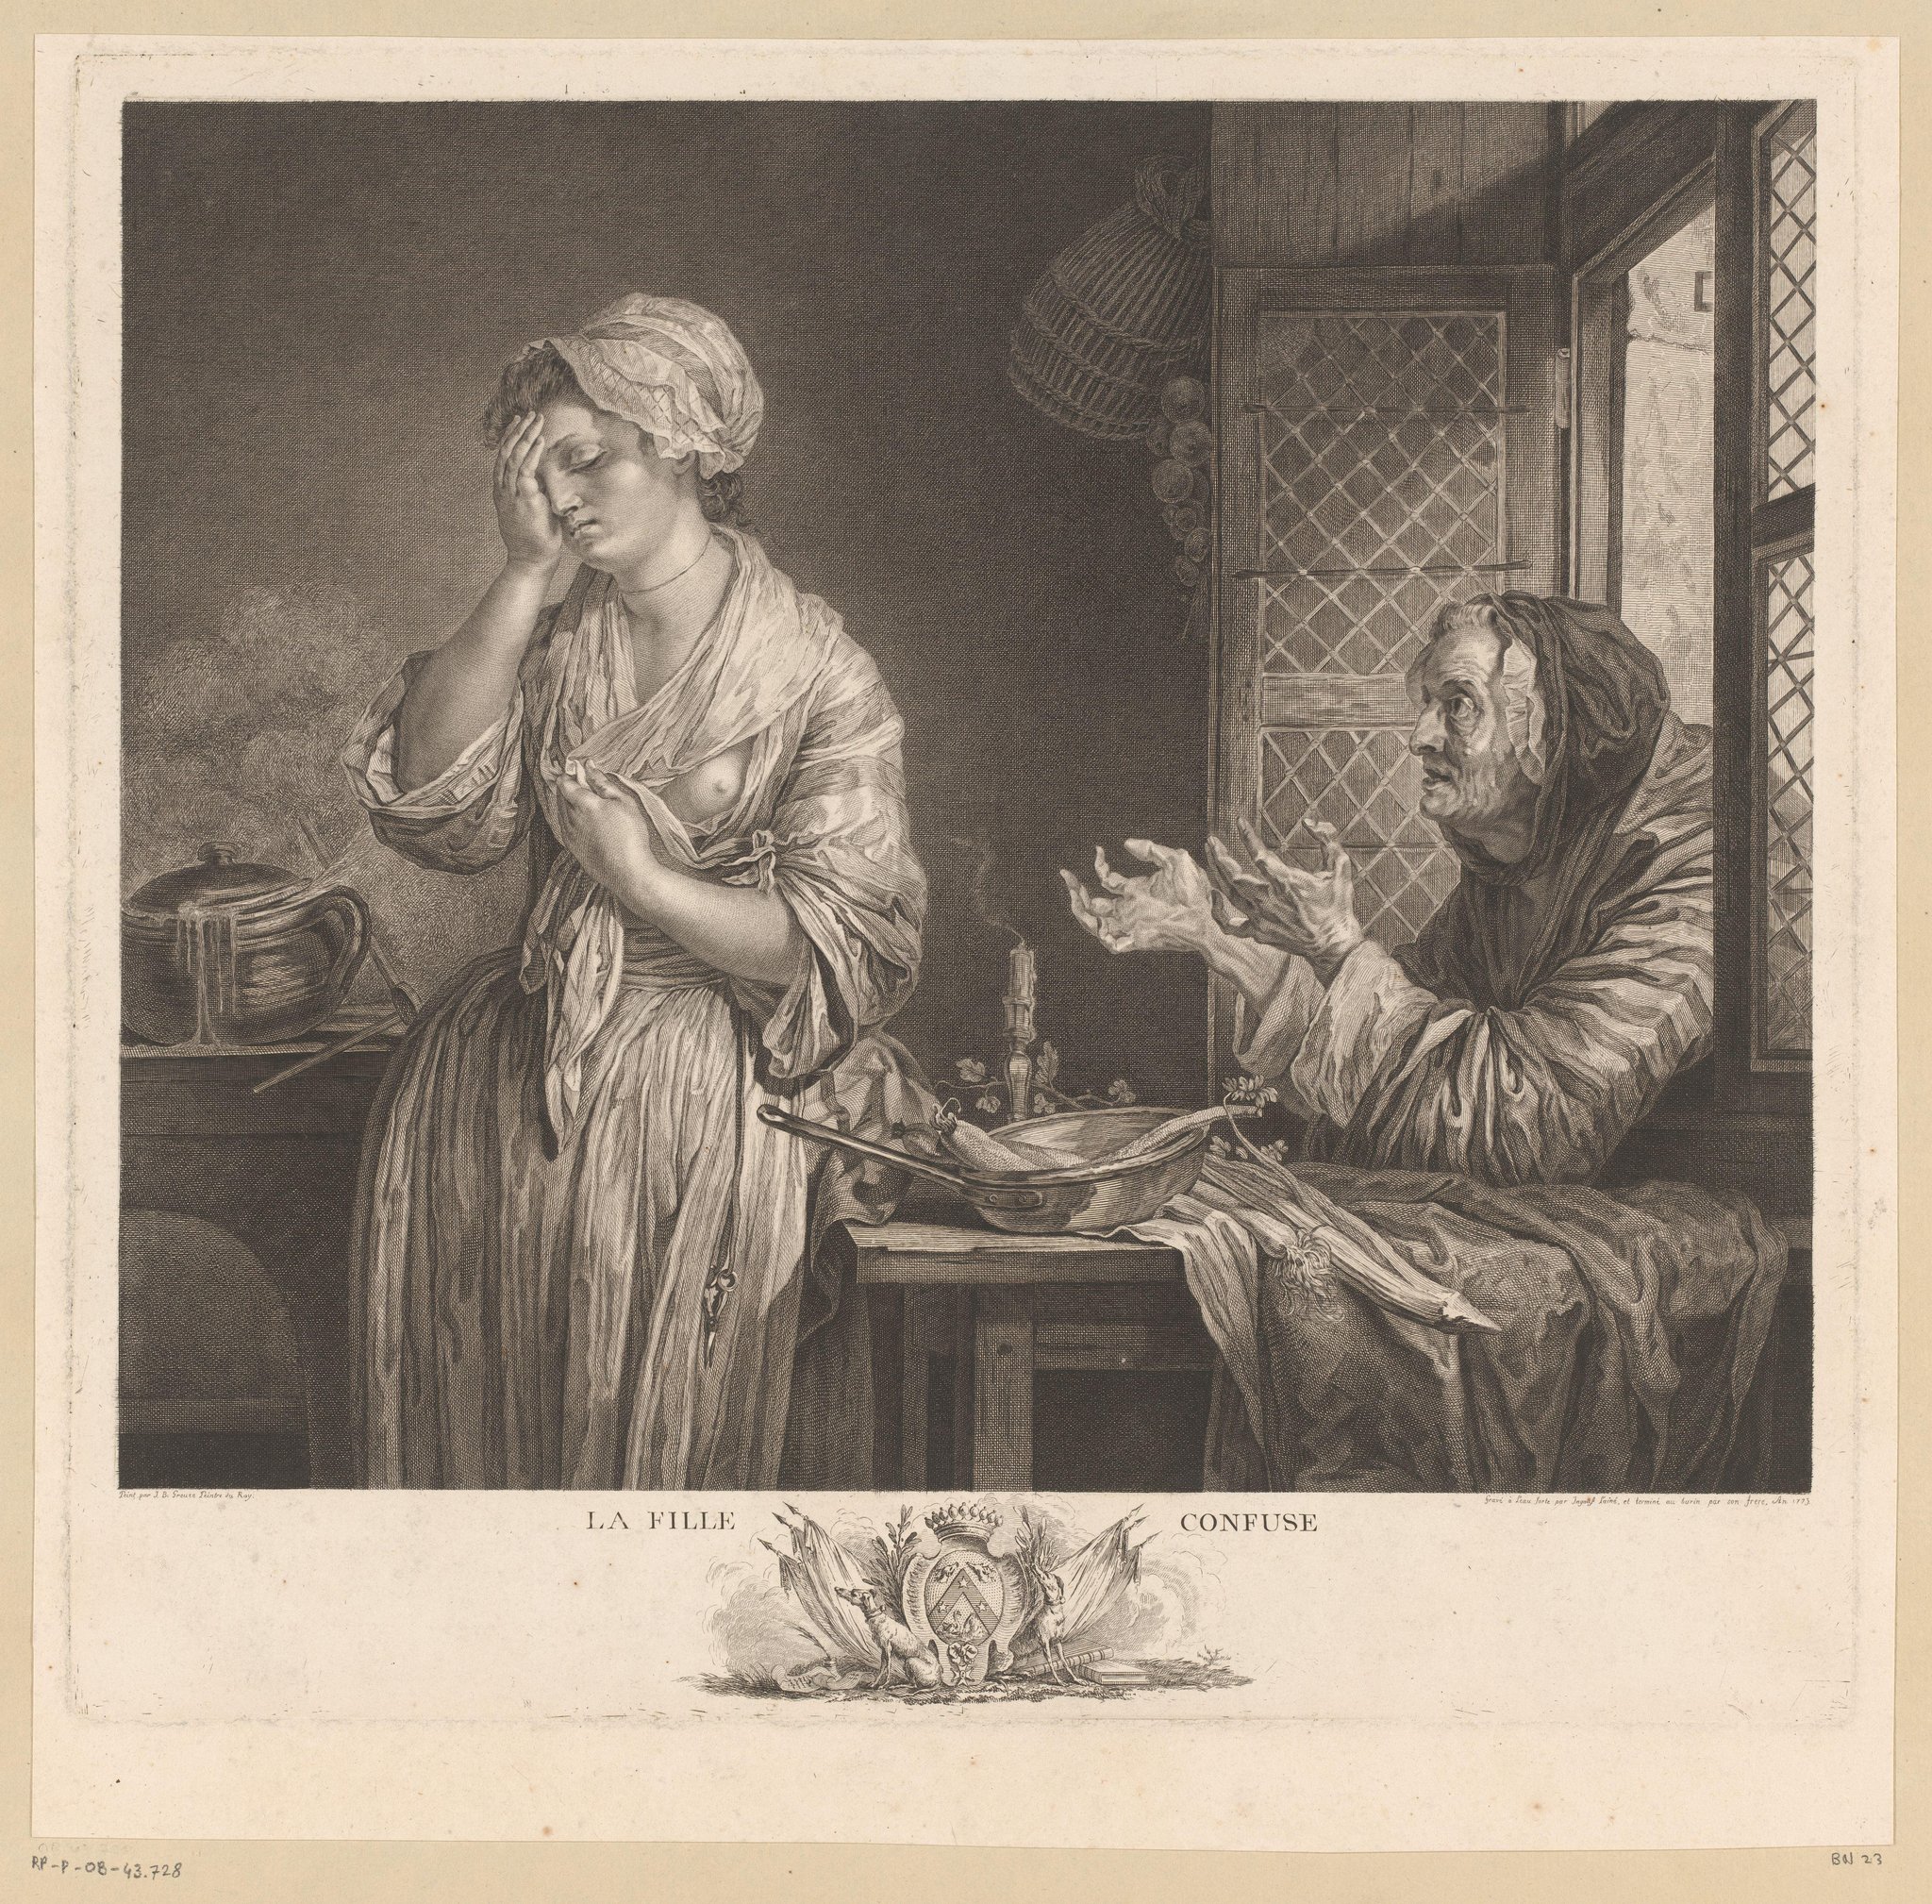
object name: print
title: La Fille Confuse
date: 1773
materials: paper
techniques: engraving, etching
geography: france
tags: kitchen, defloration, loss of virginity (and symbols), mother and daughter(s) (family group)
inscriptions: number: ‘No 594.’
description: In een keukeninterieur staat een jonge vrouw met ontblote borst. Zij houdt haar hand bij haar hoofd en kijkt in schaamte weg van een oude vrouw in het venster. De vrouw die mogelijk haar moeder is, spreekt haar met handgebaren toe. Op de achtergrond kookt een pan op het vuur over.